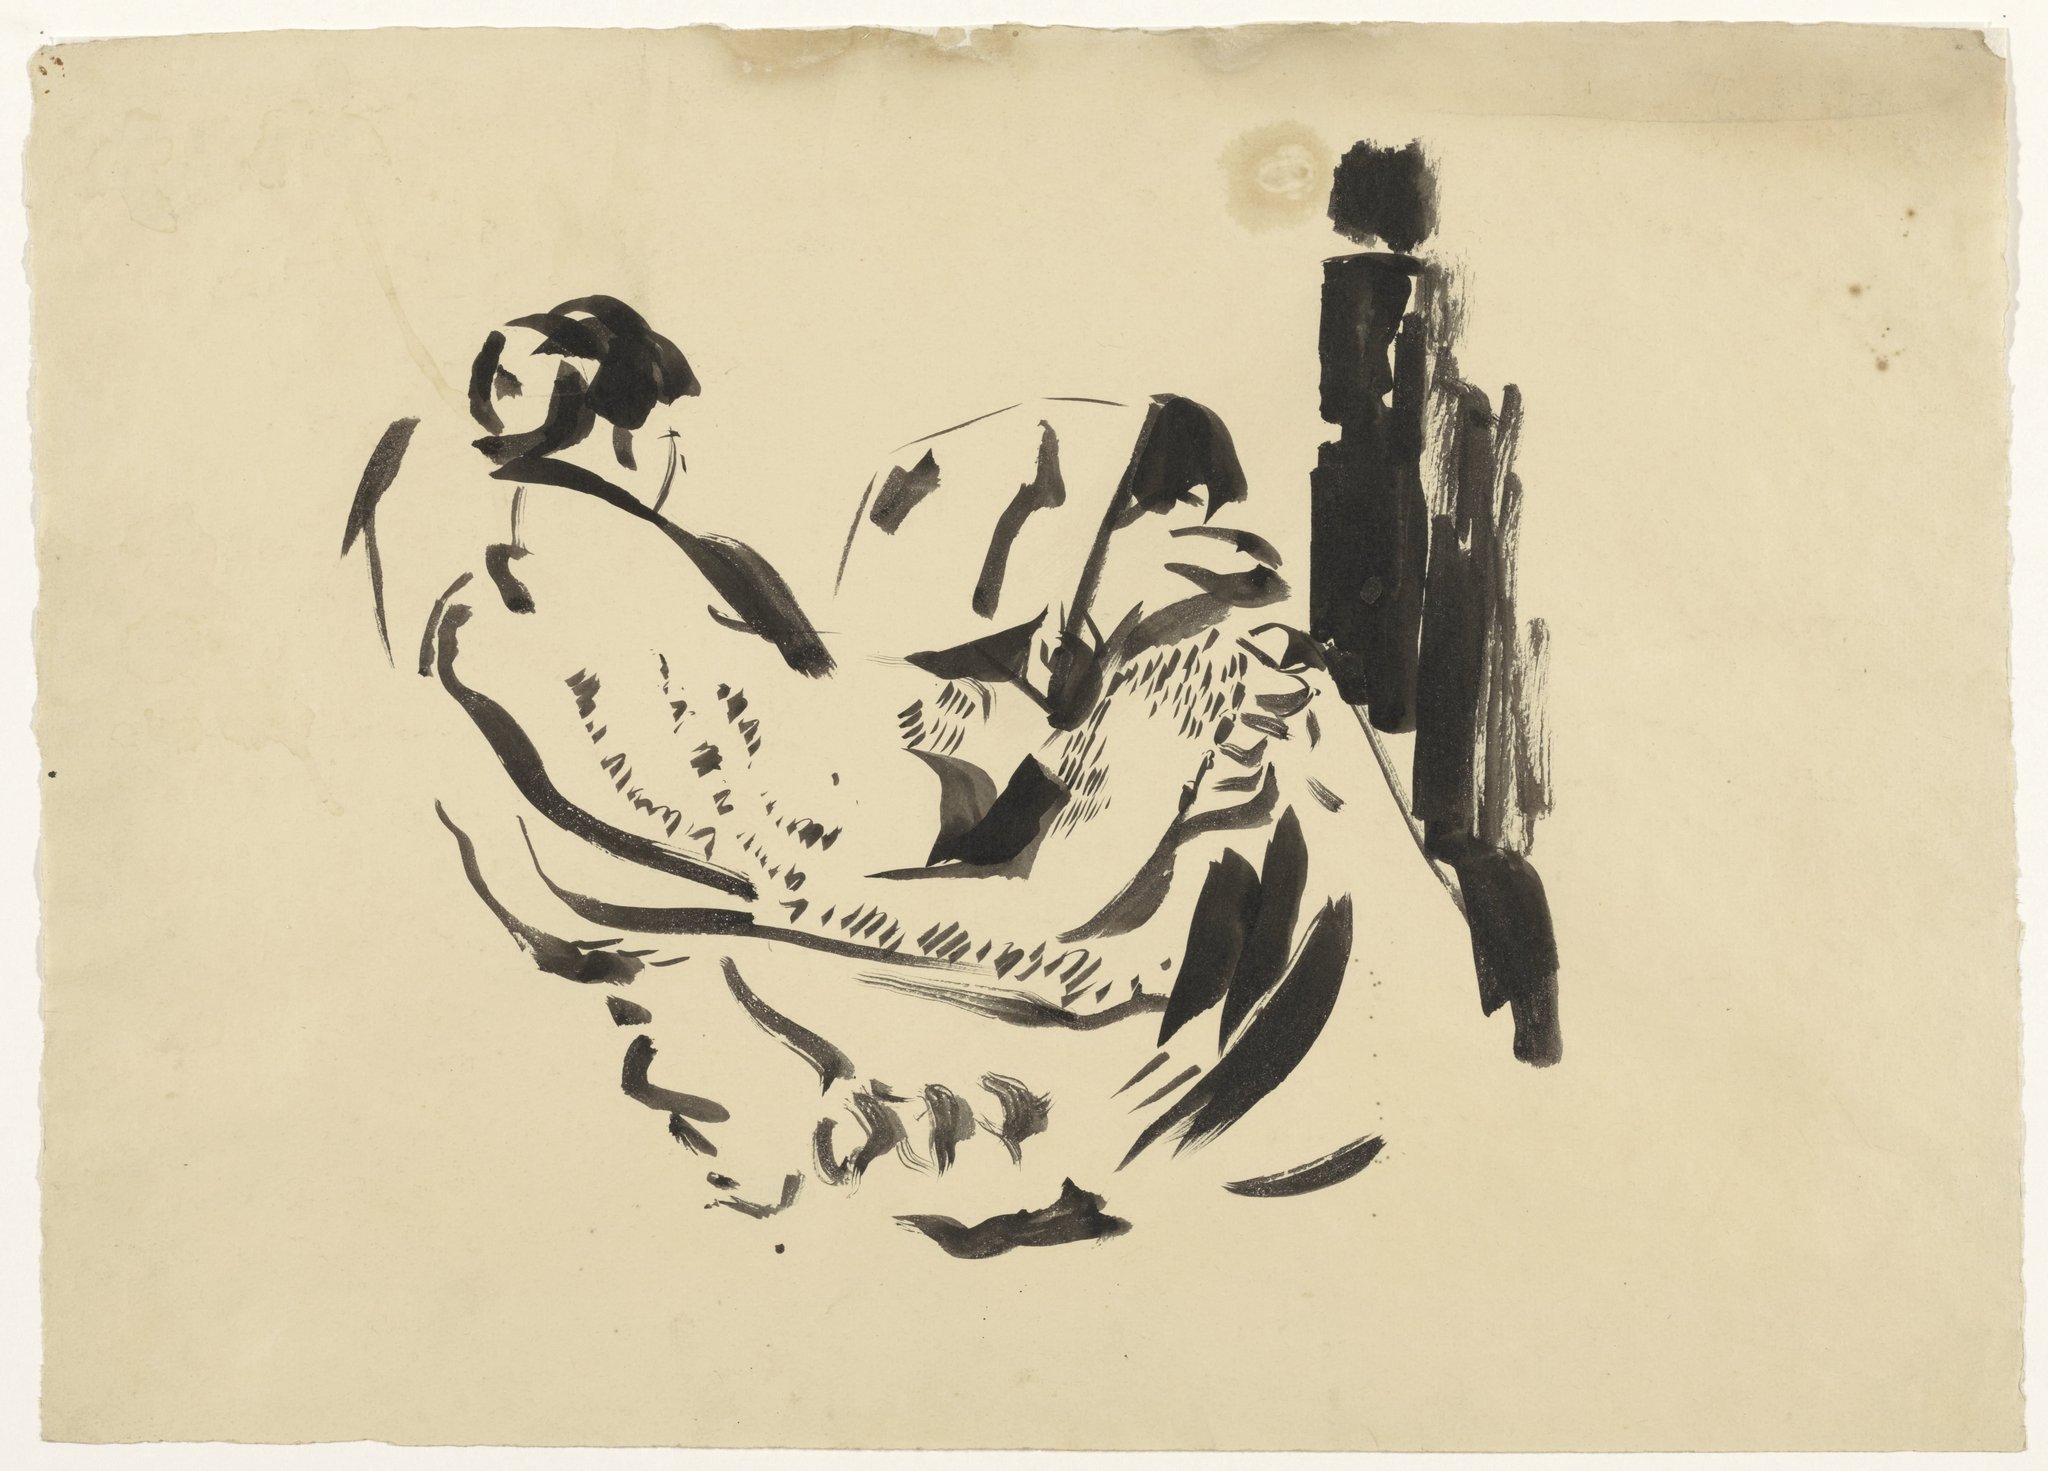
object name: drawing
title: Studie naar Nel Wouters, zittend in een leunstoel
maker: rik wouters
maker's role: draughtsman, print maker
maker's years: 1882-1916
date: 1892-1916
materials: paper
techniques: brush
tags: sitting figure - aa - female human figure